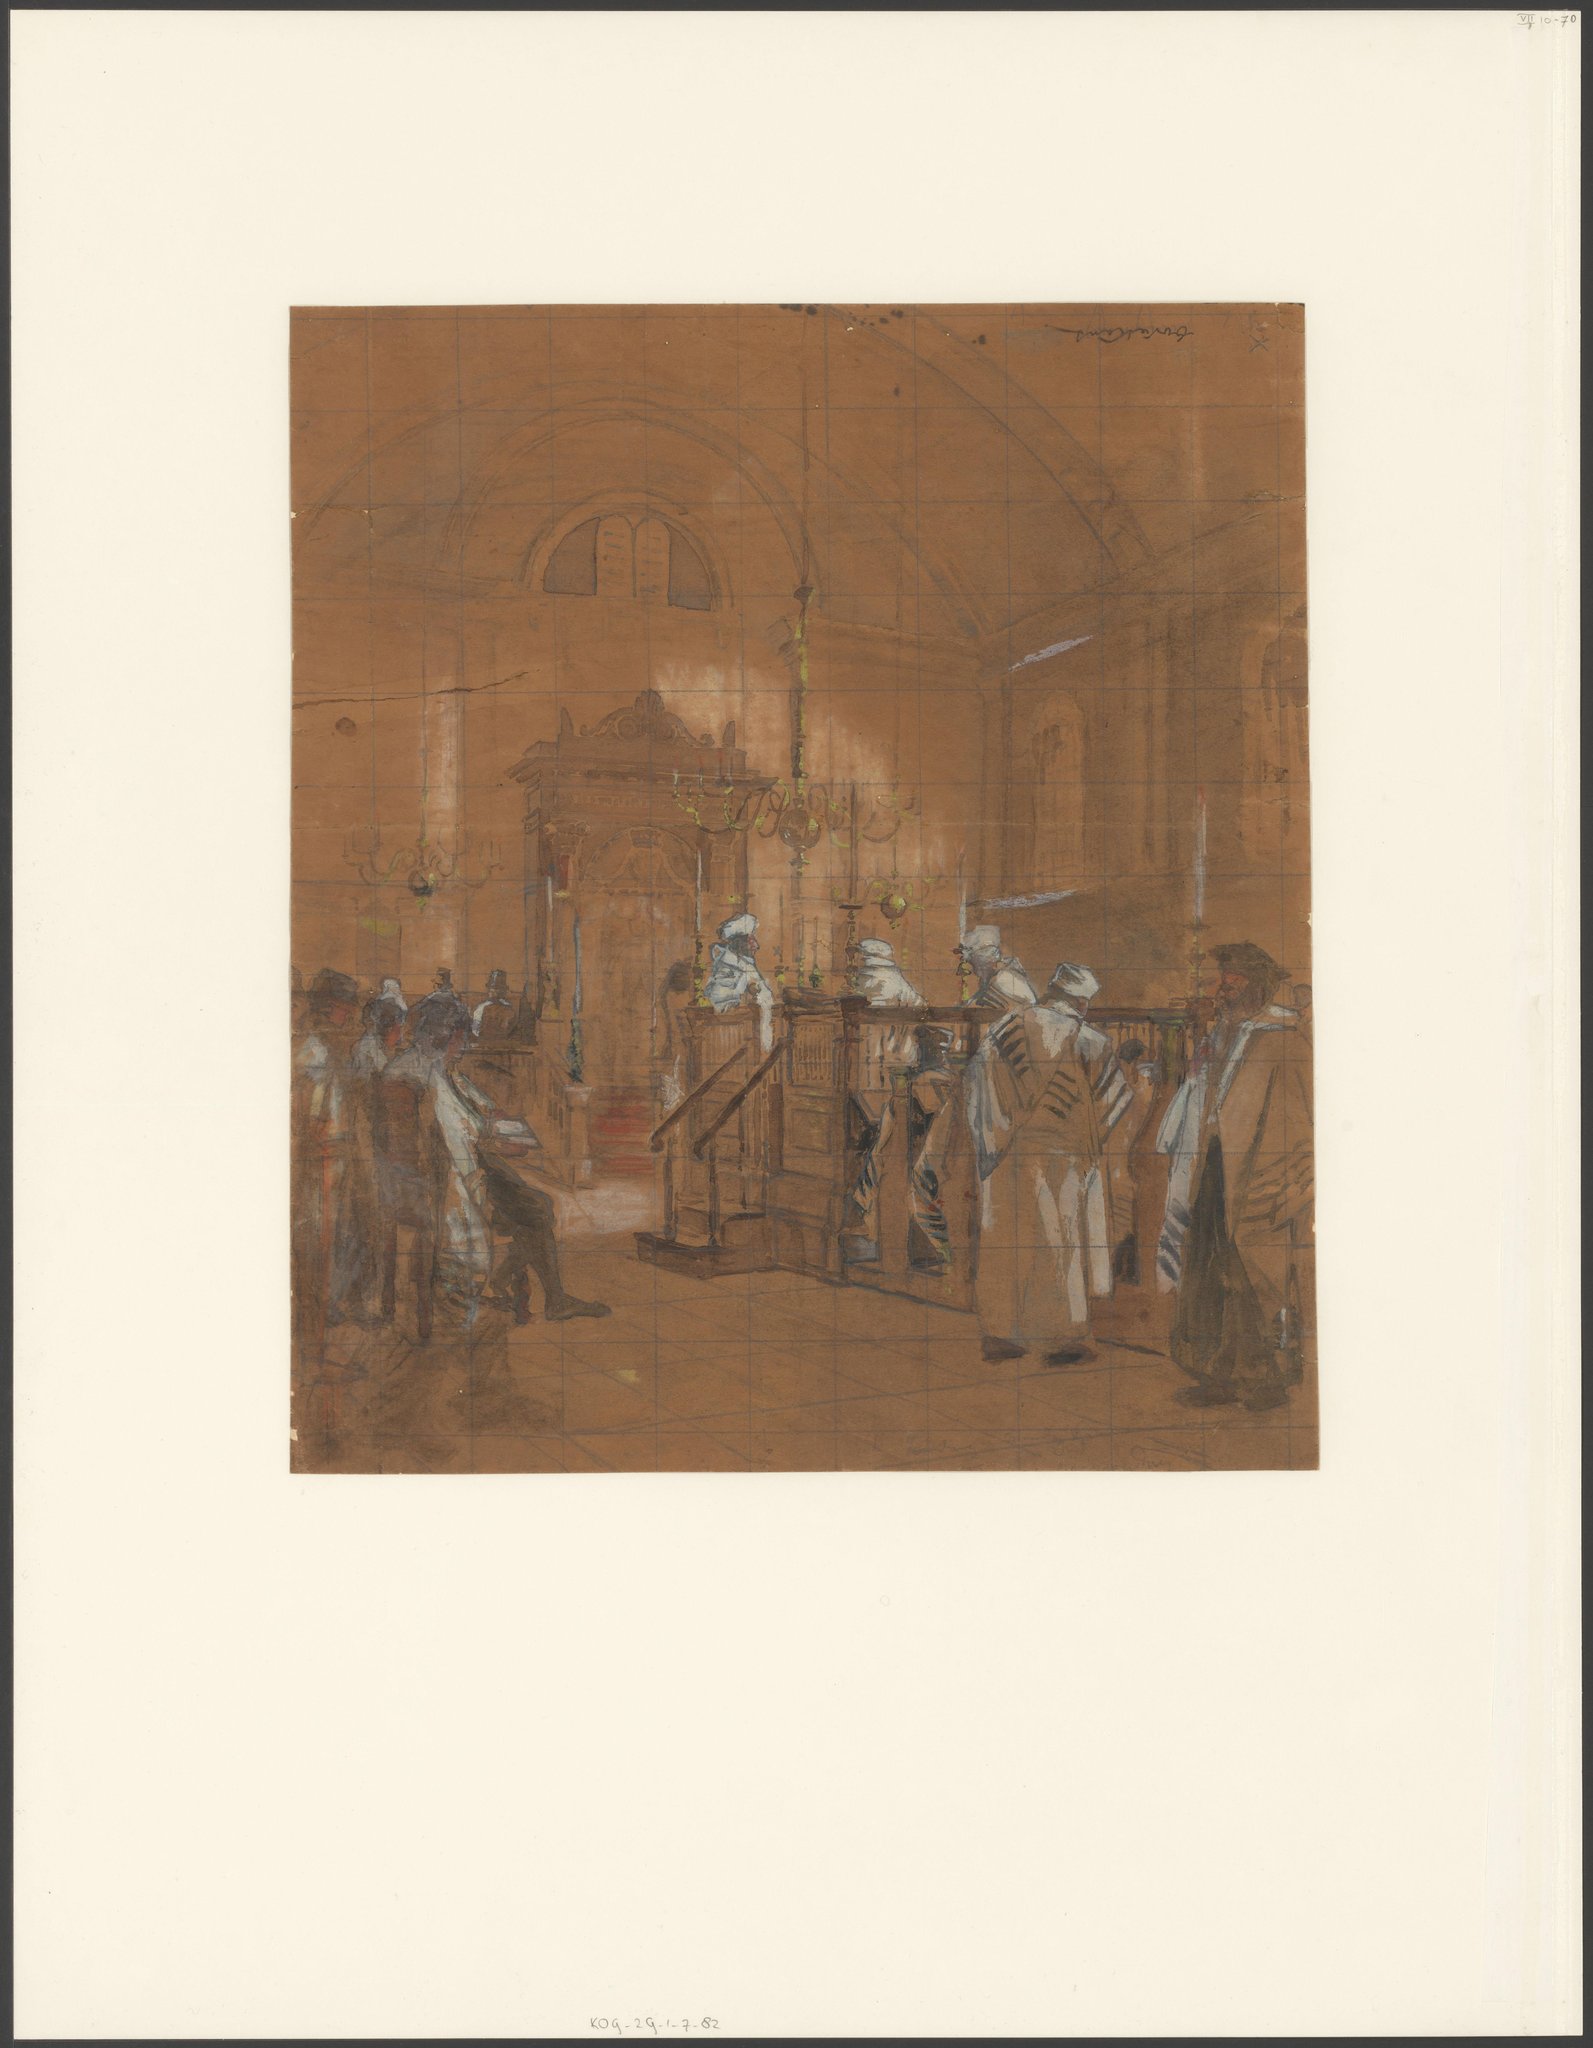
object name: drawing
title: Jom Kipoer in de voormalige synagoge in Utrecht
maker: johan paul constantinus grolman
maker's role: draughtsman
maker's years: 1841-1927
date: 1880-1899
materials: paper, pencil, watercolor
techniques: brush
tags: daily services in the synagogue ~ jewish religion, 'yom kippur' prayer in the synagogue; male worshippers wearing a white gown ('kittel') and a 'yom kippur' cap, utrecht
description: Onderwerpsrubrieken binnen de Atlas Zeden en Gewoonten: Godsdienst, Israëlieten.